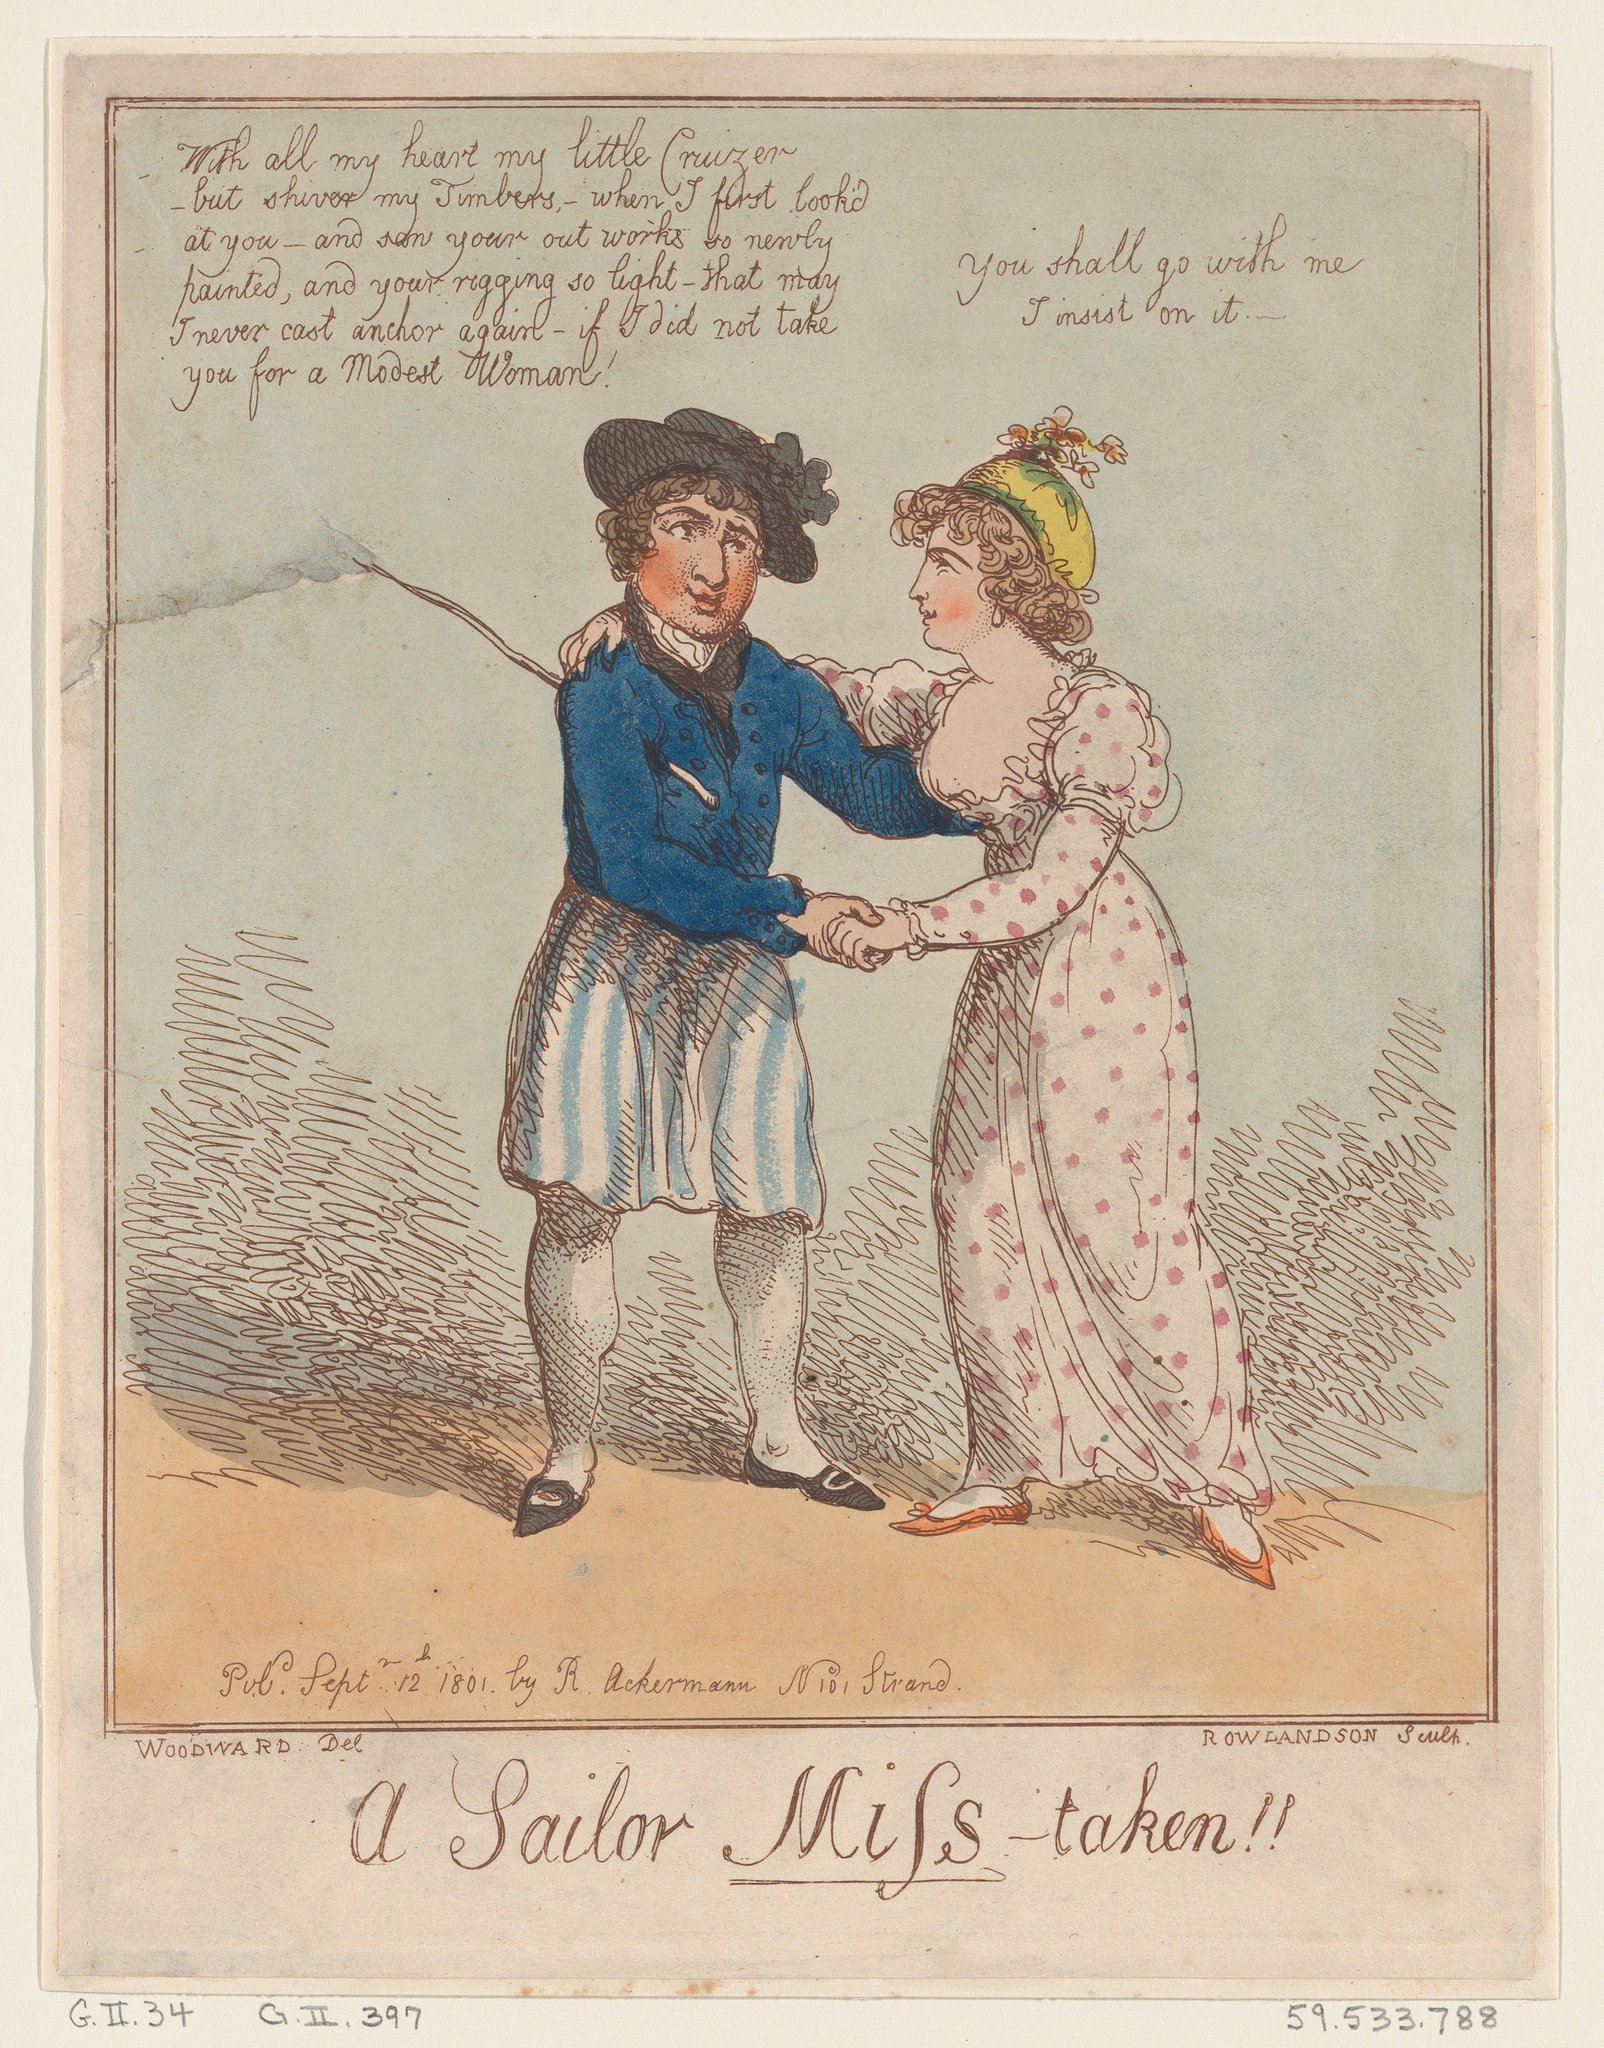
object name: print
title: A Sailor Miss-taken!!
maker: thomas rowlandson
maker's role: artist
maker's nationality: british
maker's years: 1757-1827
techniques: etching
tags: couples,men,women,sailors